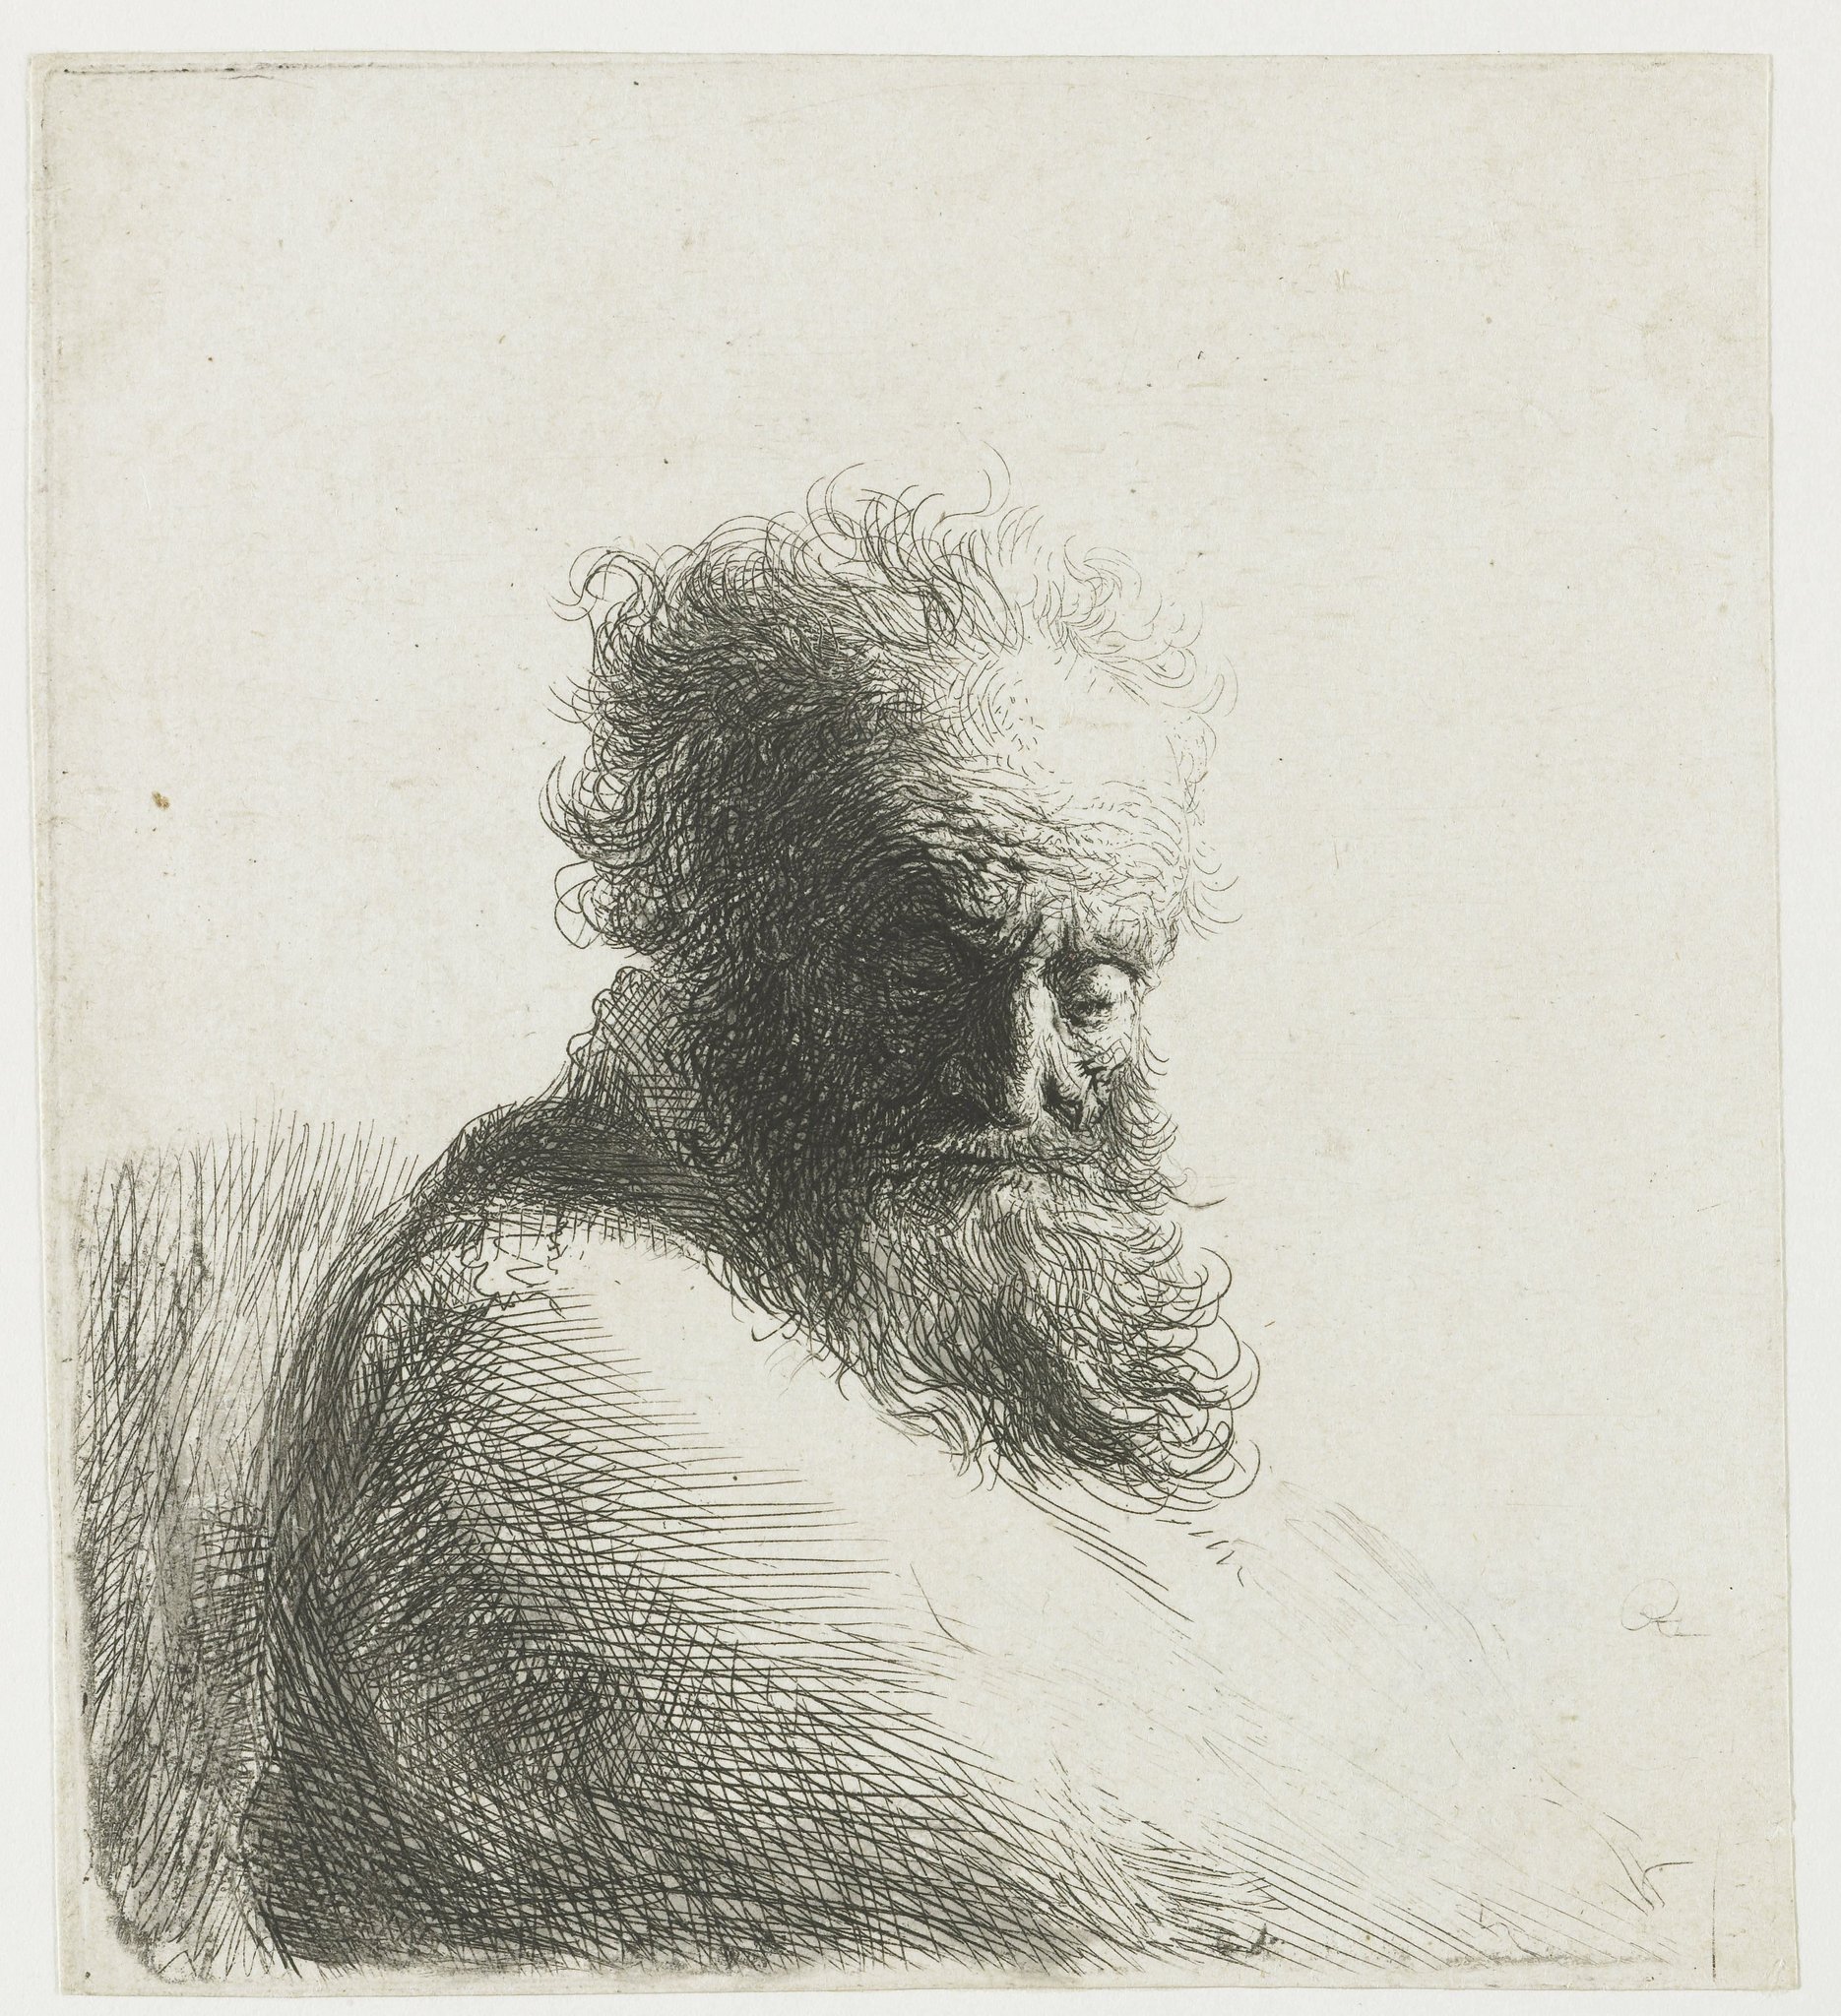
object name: print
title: Bust of an old bearded man, looking down, three quarters right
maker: rembrandt van rijn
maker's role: draughtsman, painter, print maker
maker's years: 1606-1669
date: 1631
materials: paper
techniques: etching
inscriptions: mark: Lugt 2165, mark: Lugt 699, monogram and date: ‘RHL 16 (laatste twee getallen weggevallen)’